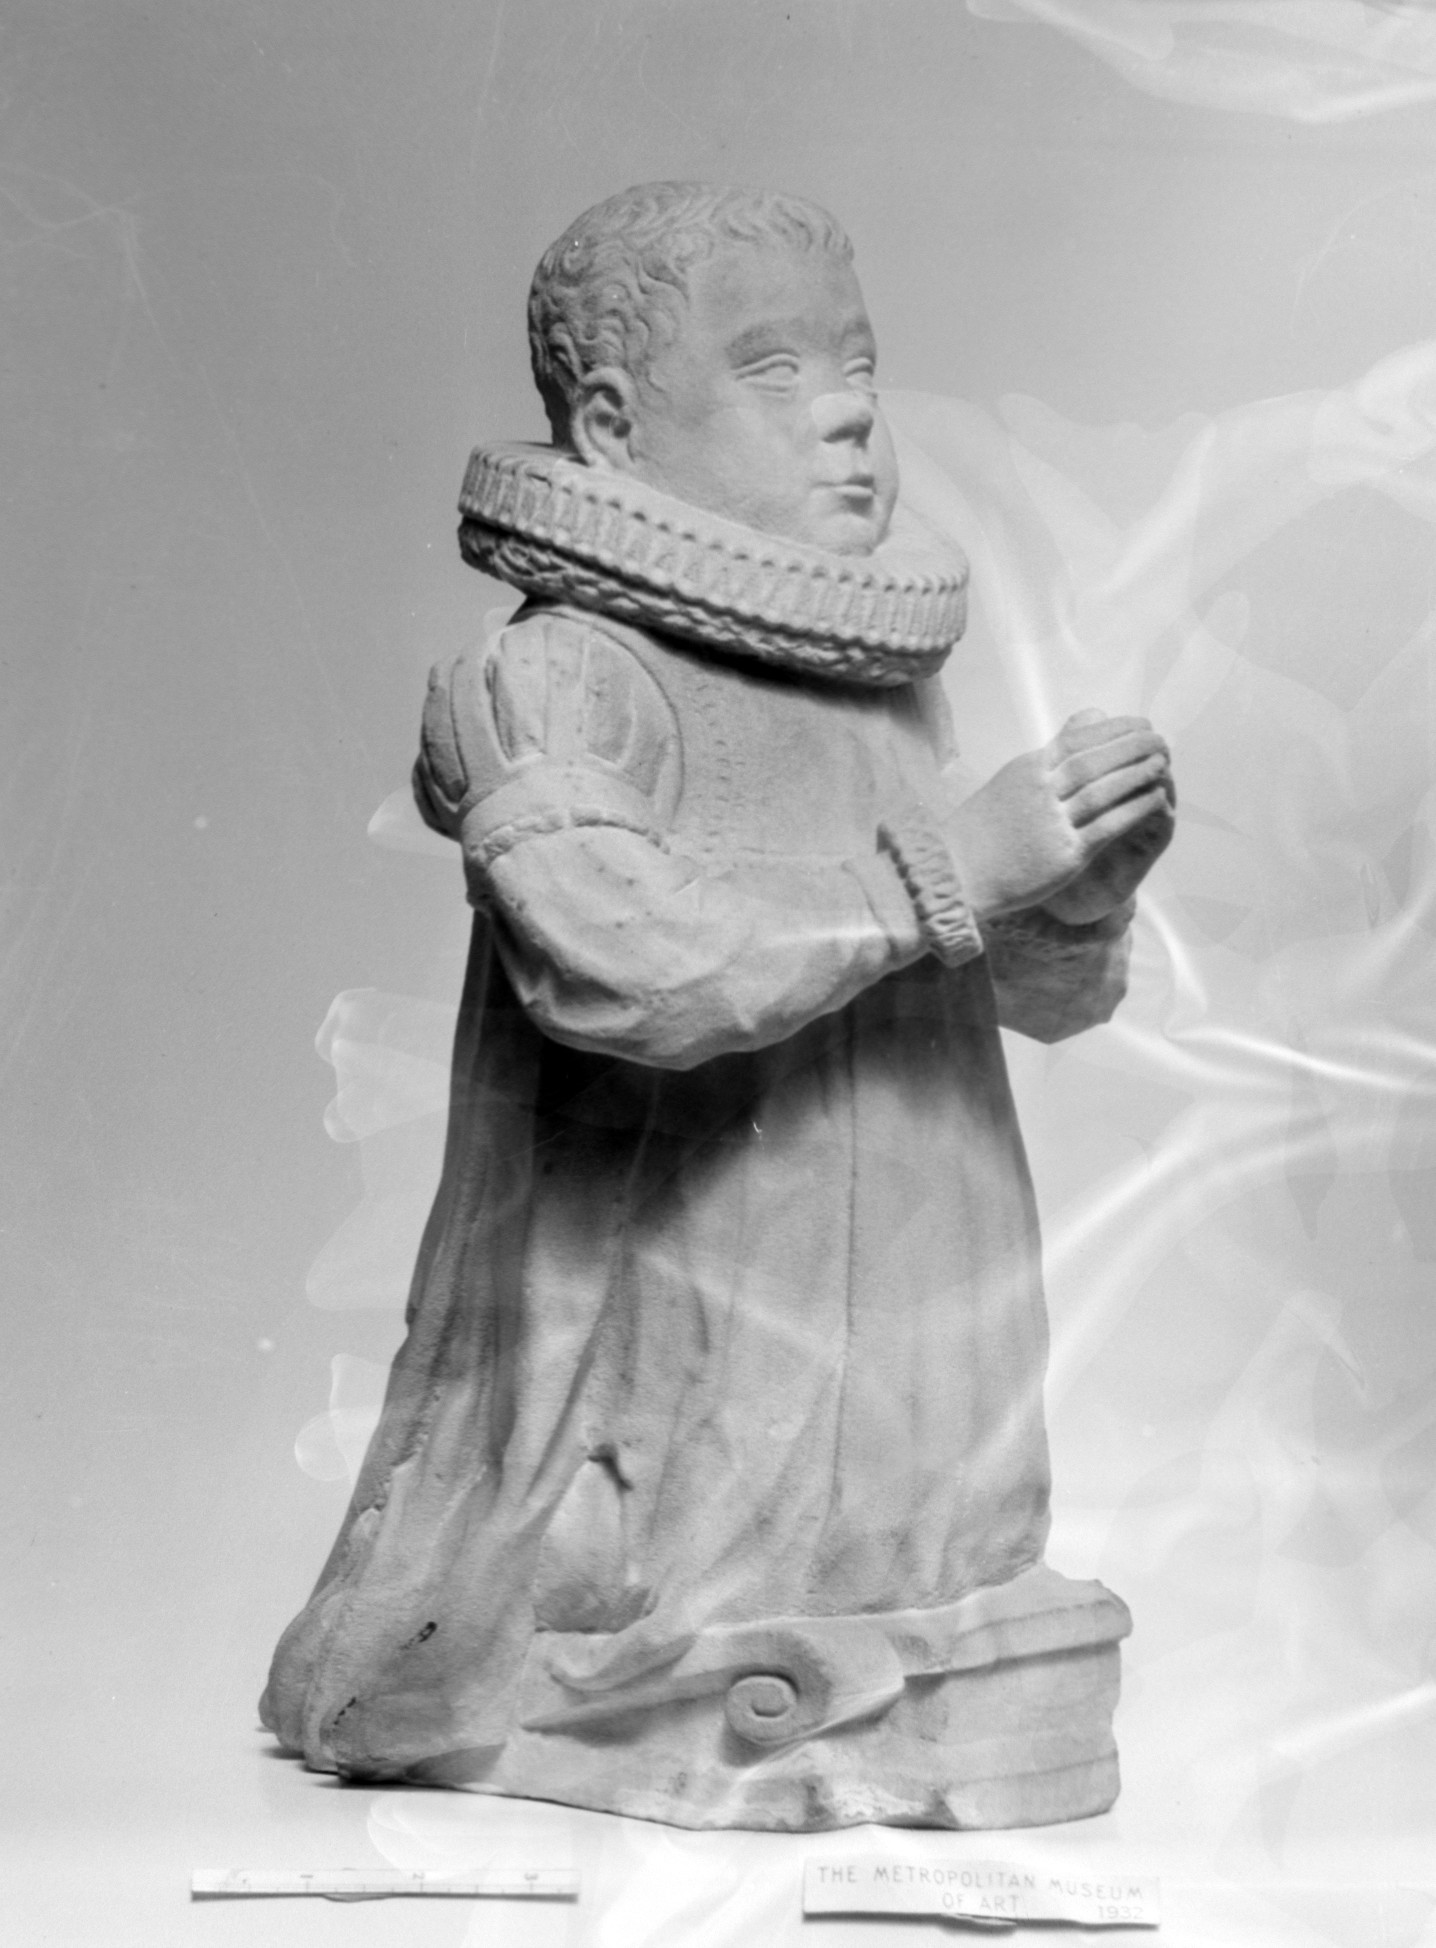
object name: statuette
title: Kneeling boy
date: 1501-1700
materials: stone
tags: boys